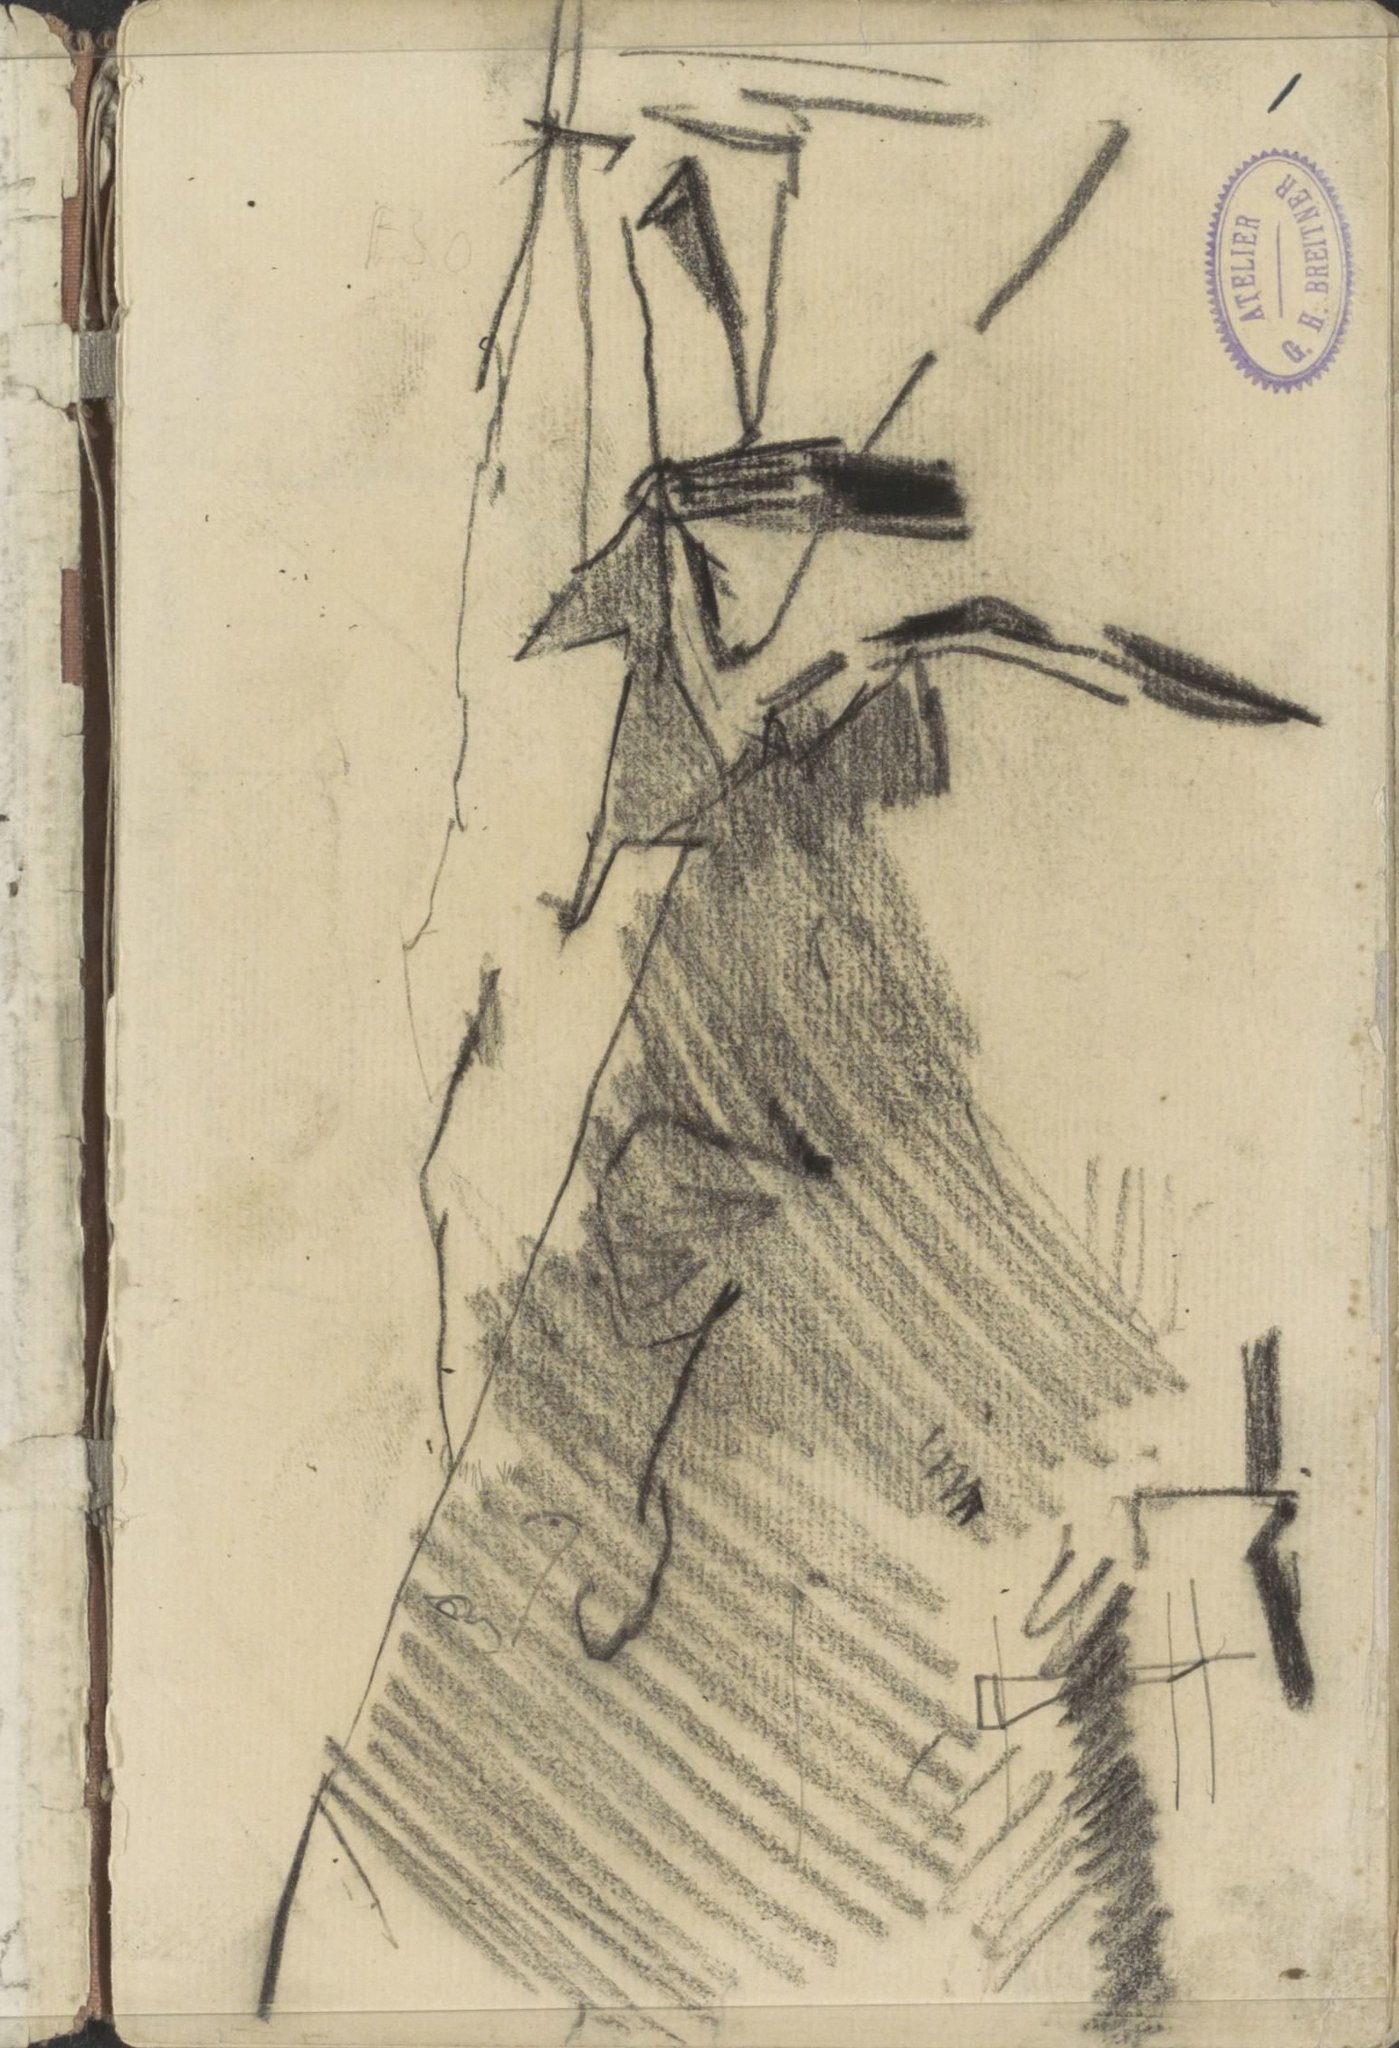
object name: sketchbook leaf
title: Figuur op een pad, mogelijk in een duinlandschap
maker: george hendrik breitner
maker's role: draughtsman, painter, print maker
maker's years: 1857-1923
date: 1881-1883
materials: chalk, paper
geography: the hague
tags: road, path, dunes (sea not visible); in the dunes (+ landscape with figures, staffage), the hague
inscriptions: workshop stamp: Lugt 291d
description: Blad 1 recto uit een schetsboek met 9 bladen.